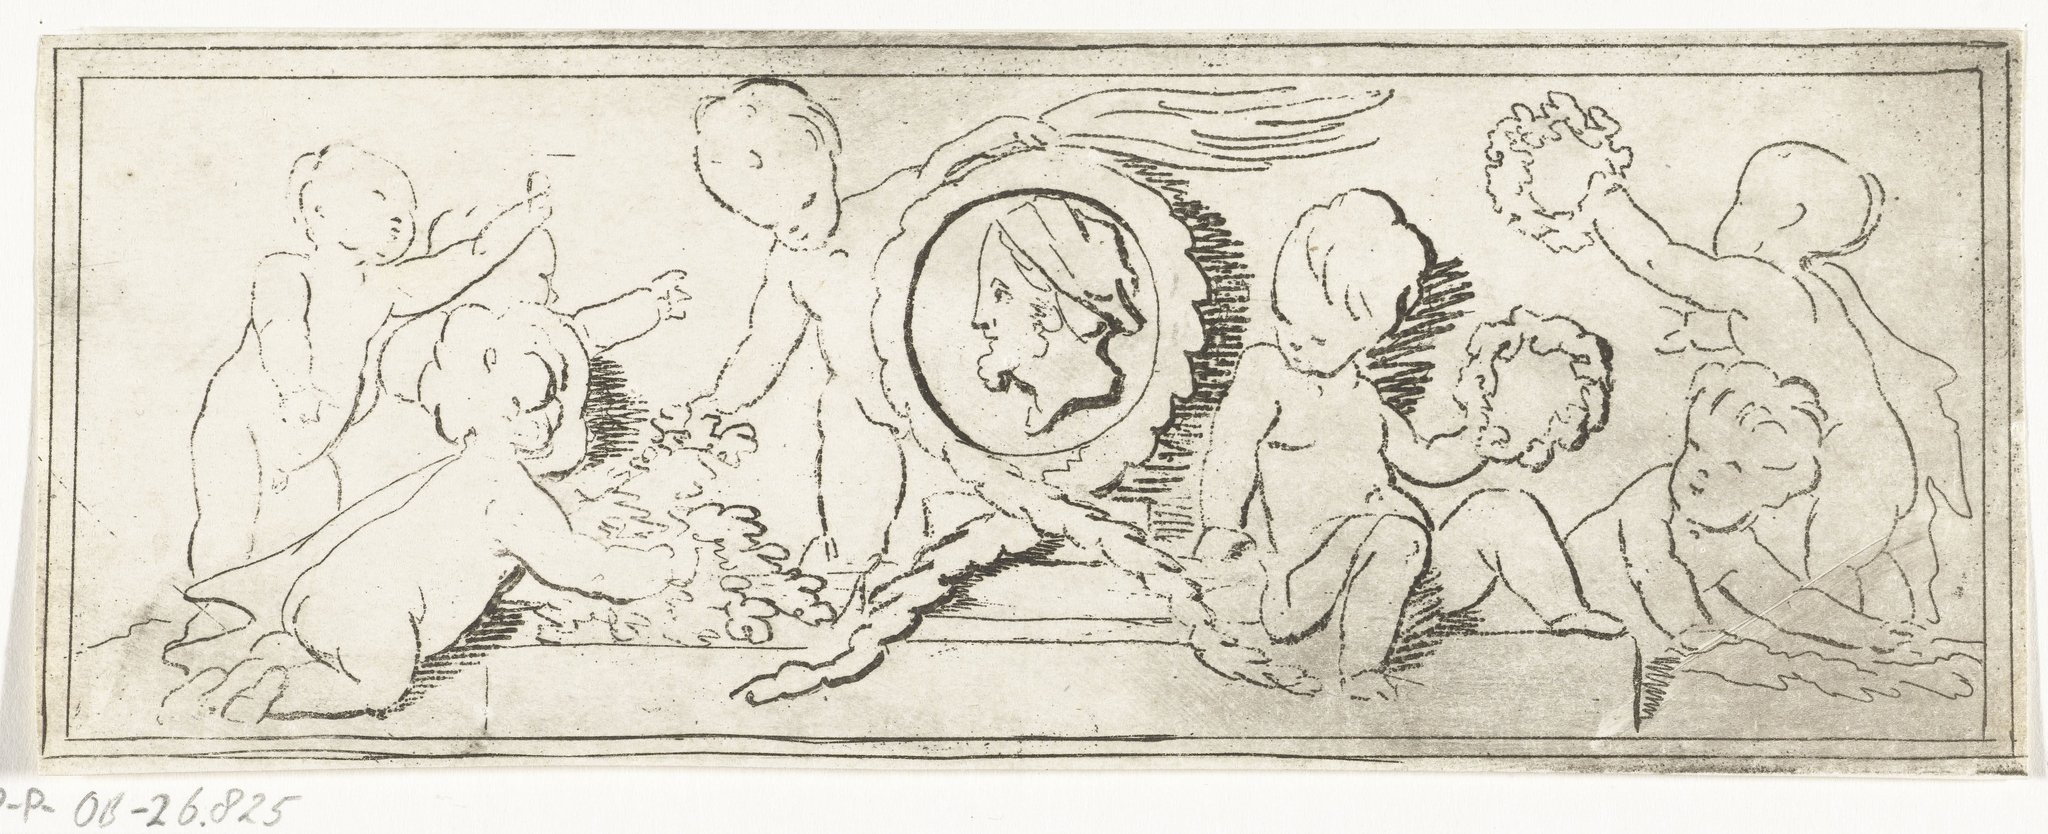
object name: print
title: Fries met putti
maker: anthonie van den bos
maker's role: draughtsman, print maker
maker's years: 1763-1838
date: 1778-1838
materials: paper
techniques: etching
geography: netherlands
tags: cupids: 'amores', 'amoretti', 'putti'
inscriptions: collector's mark: Lugt 2228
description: Zeven putti met bloemenkransen op een fries. In het midden een medaillon met een mannenportret en profiel.